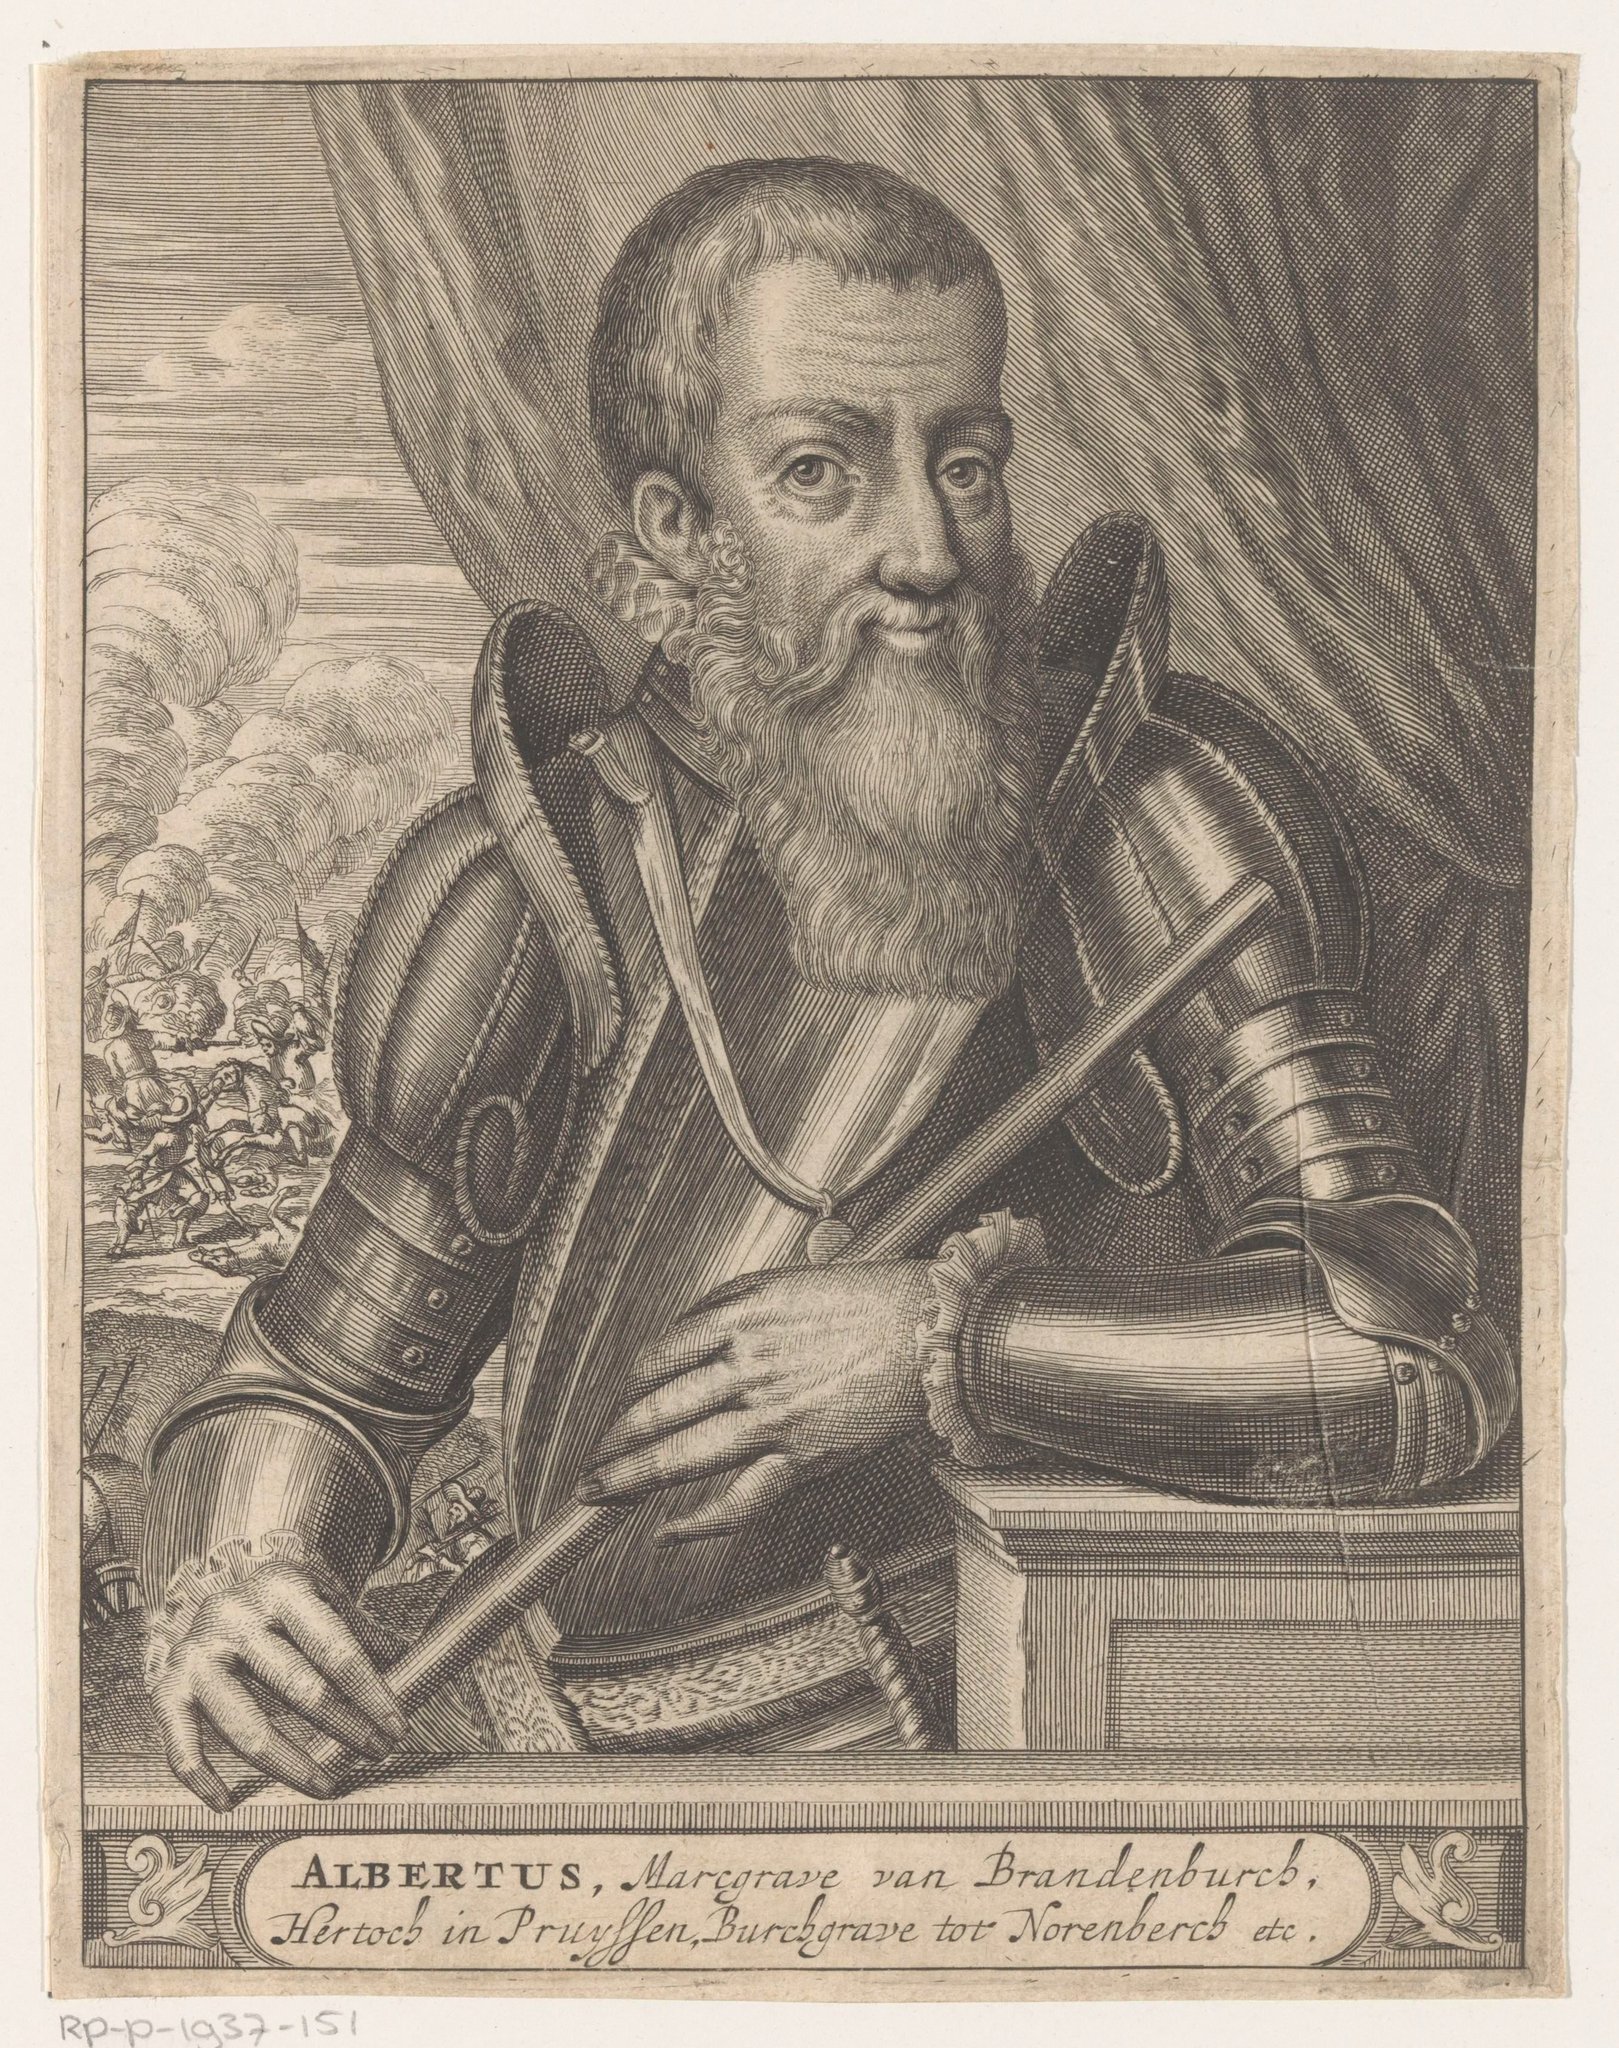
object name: print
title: Portret van Albrecht van Pruisen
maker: Anonymous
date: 1600-1699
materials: paper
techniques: engraving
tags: ansbach, tapiau (oost-pruisen), hertog, albrecht van brandenburg-ansbach (hertog van pruisen)